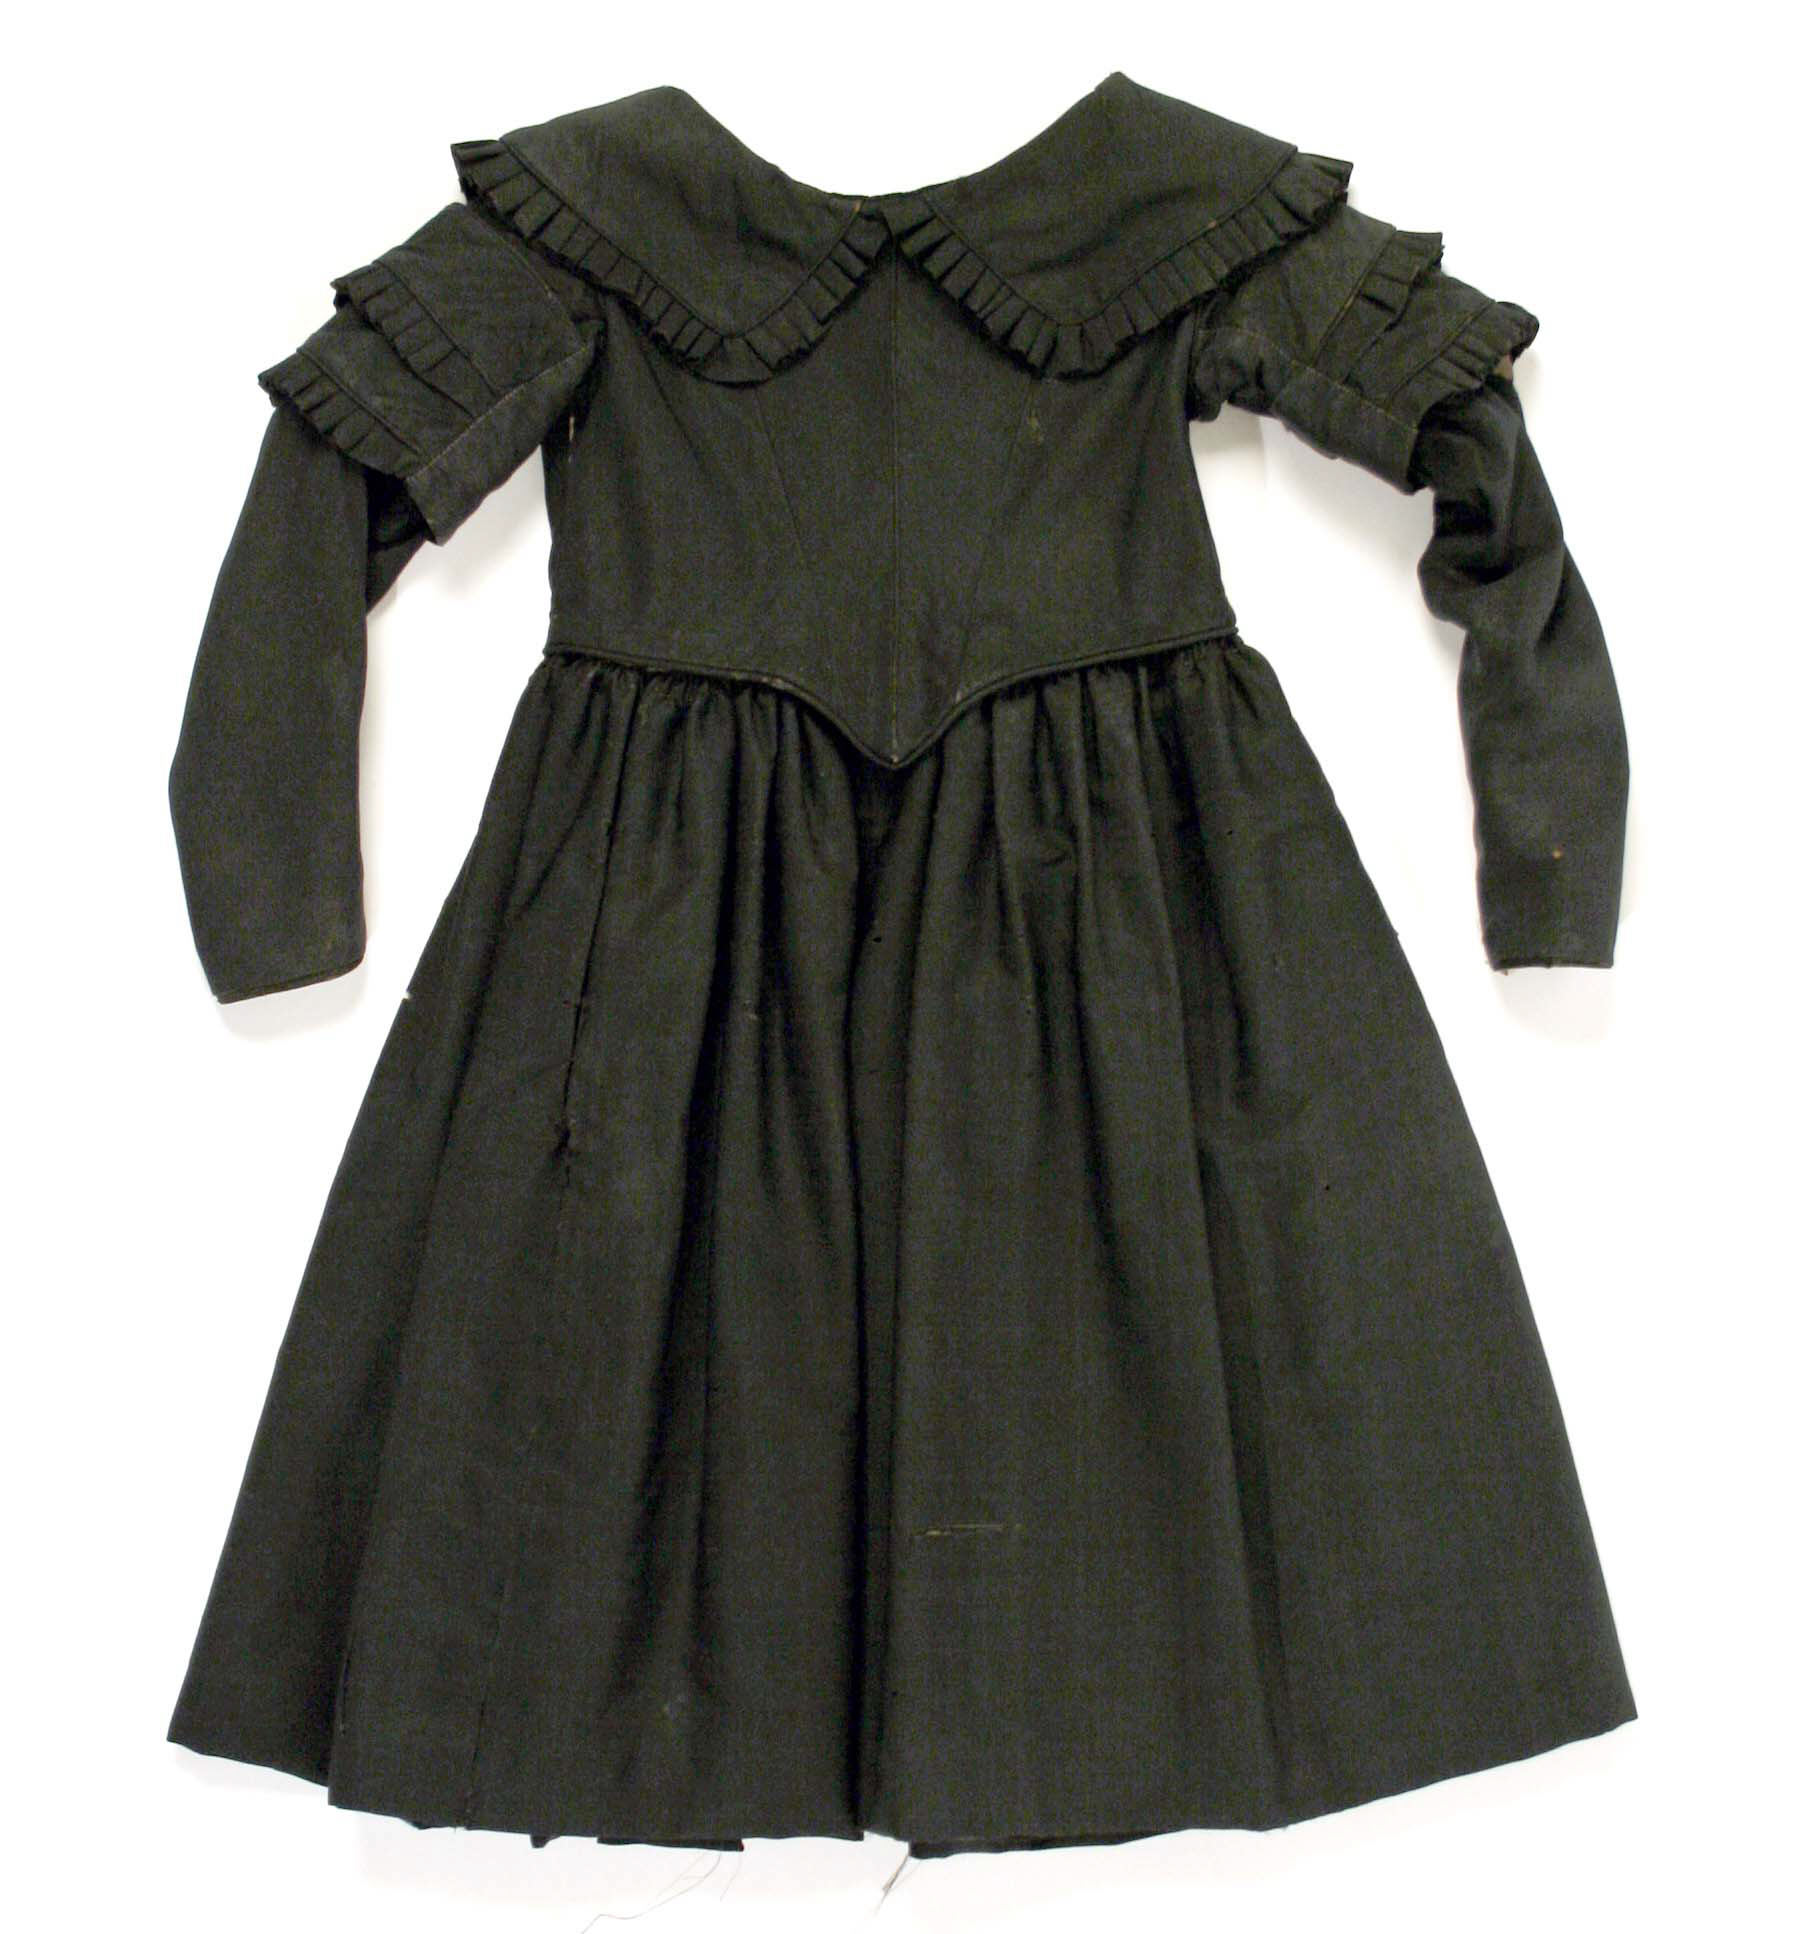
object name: mourning dress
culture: american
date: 1844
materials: silk, wool